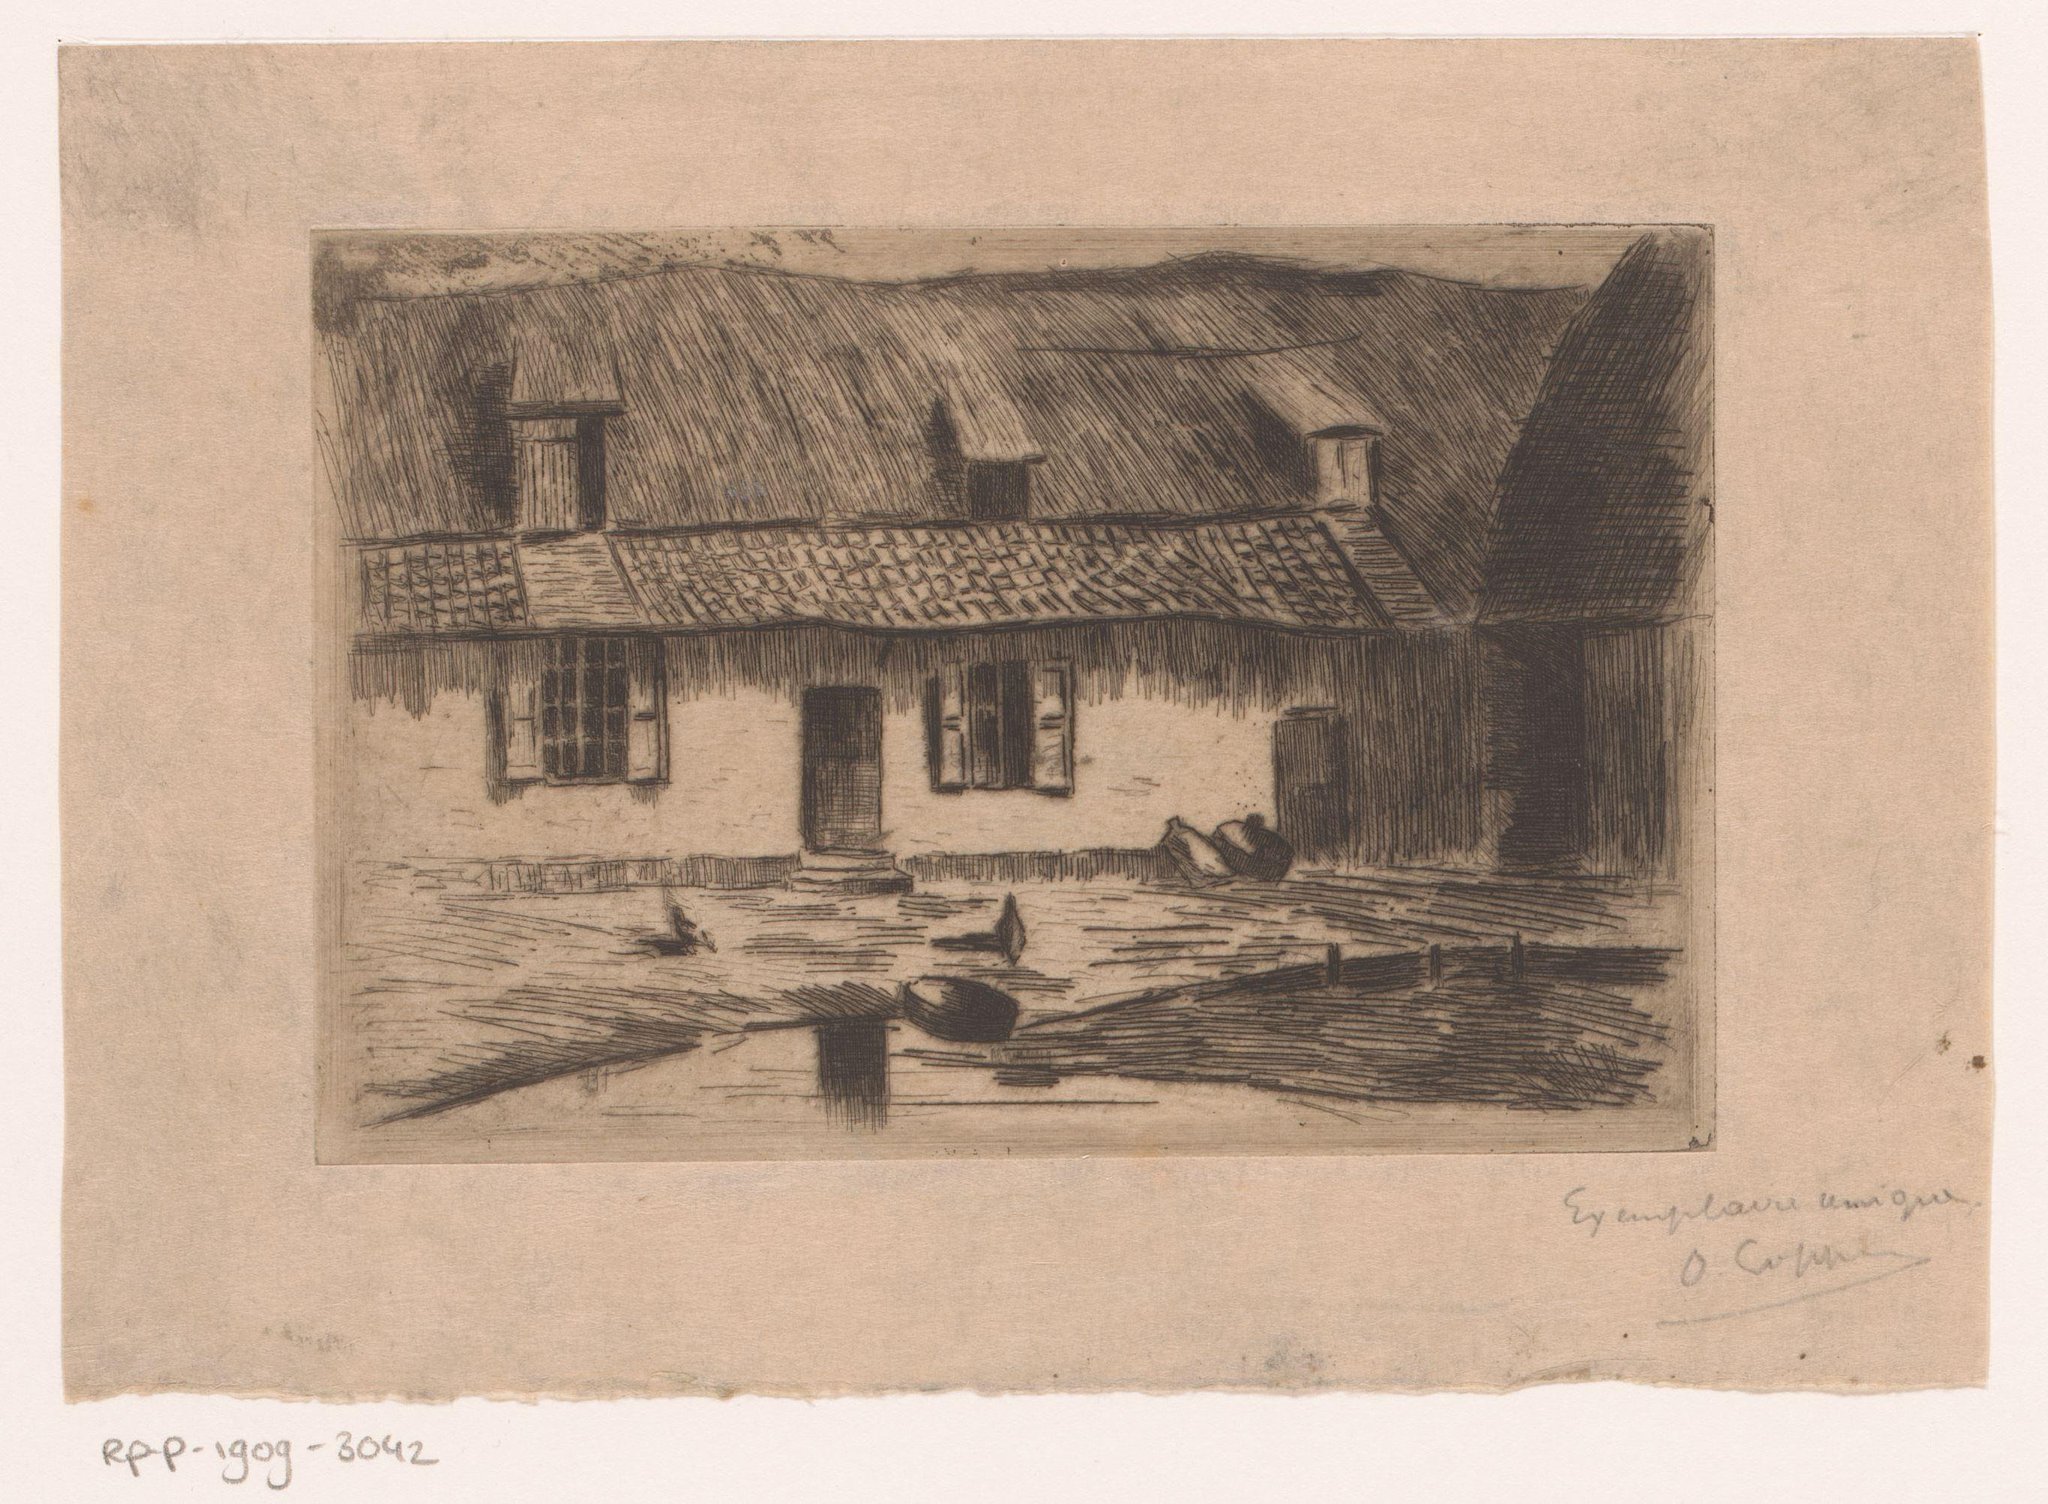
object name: print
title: Gezicht op een boerenwoning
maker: omer coppens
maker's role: print maker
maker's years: 1864-1926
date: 1874-1909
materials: paper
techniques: drypoint, etching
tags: farm (building)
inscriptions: inscription: ‘11 Vue d'une ferme’, inscription: ‘Exemplaire unique’, collector's mark: Lugt 2228